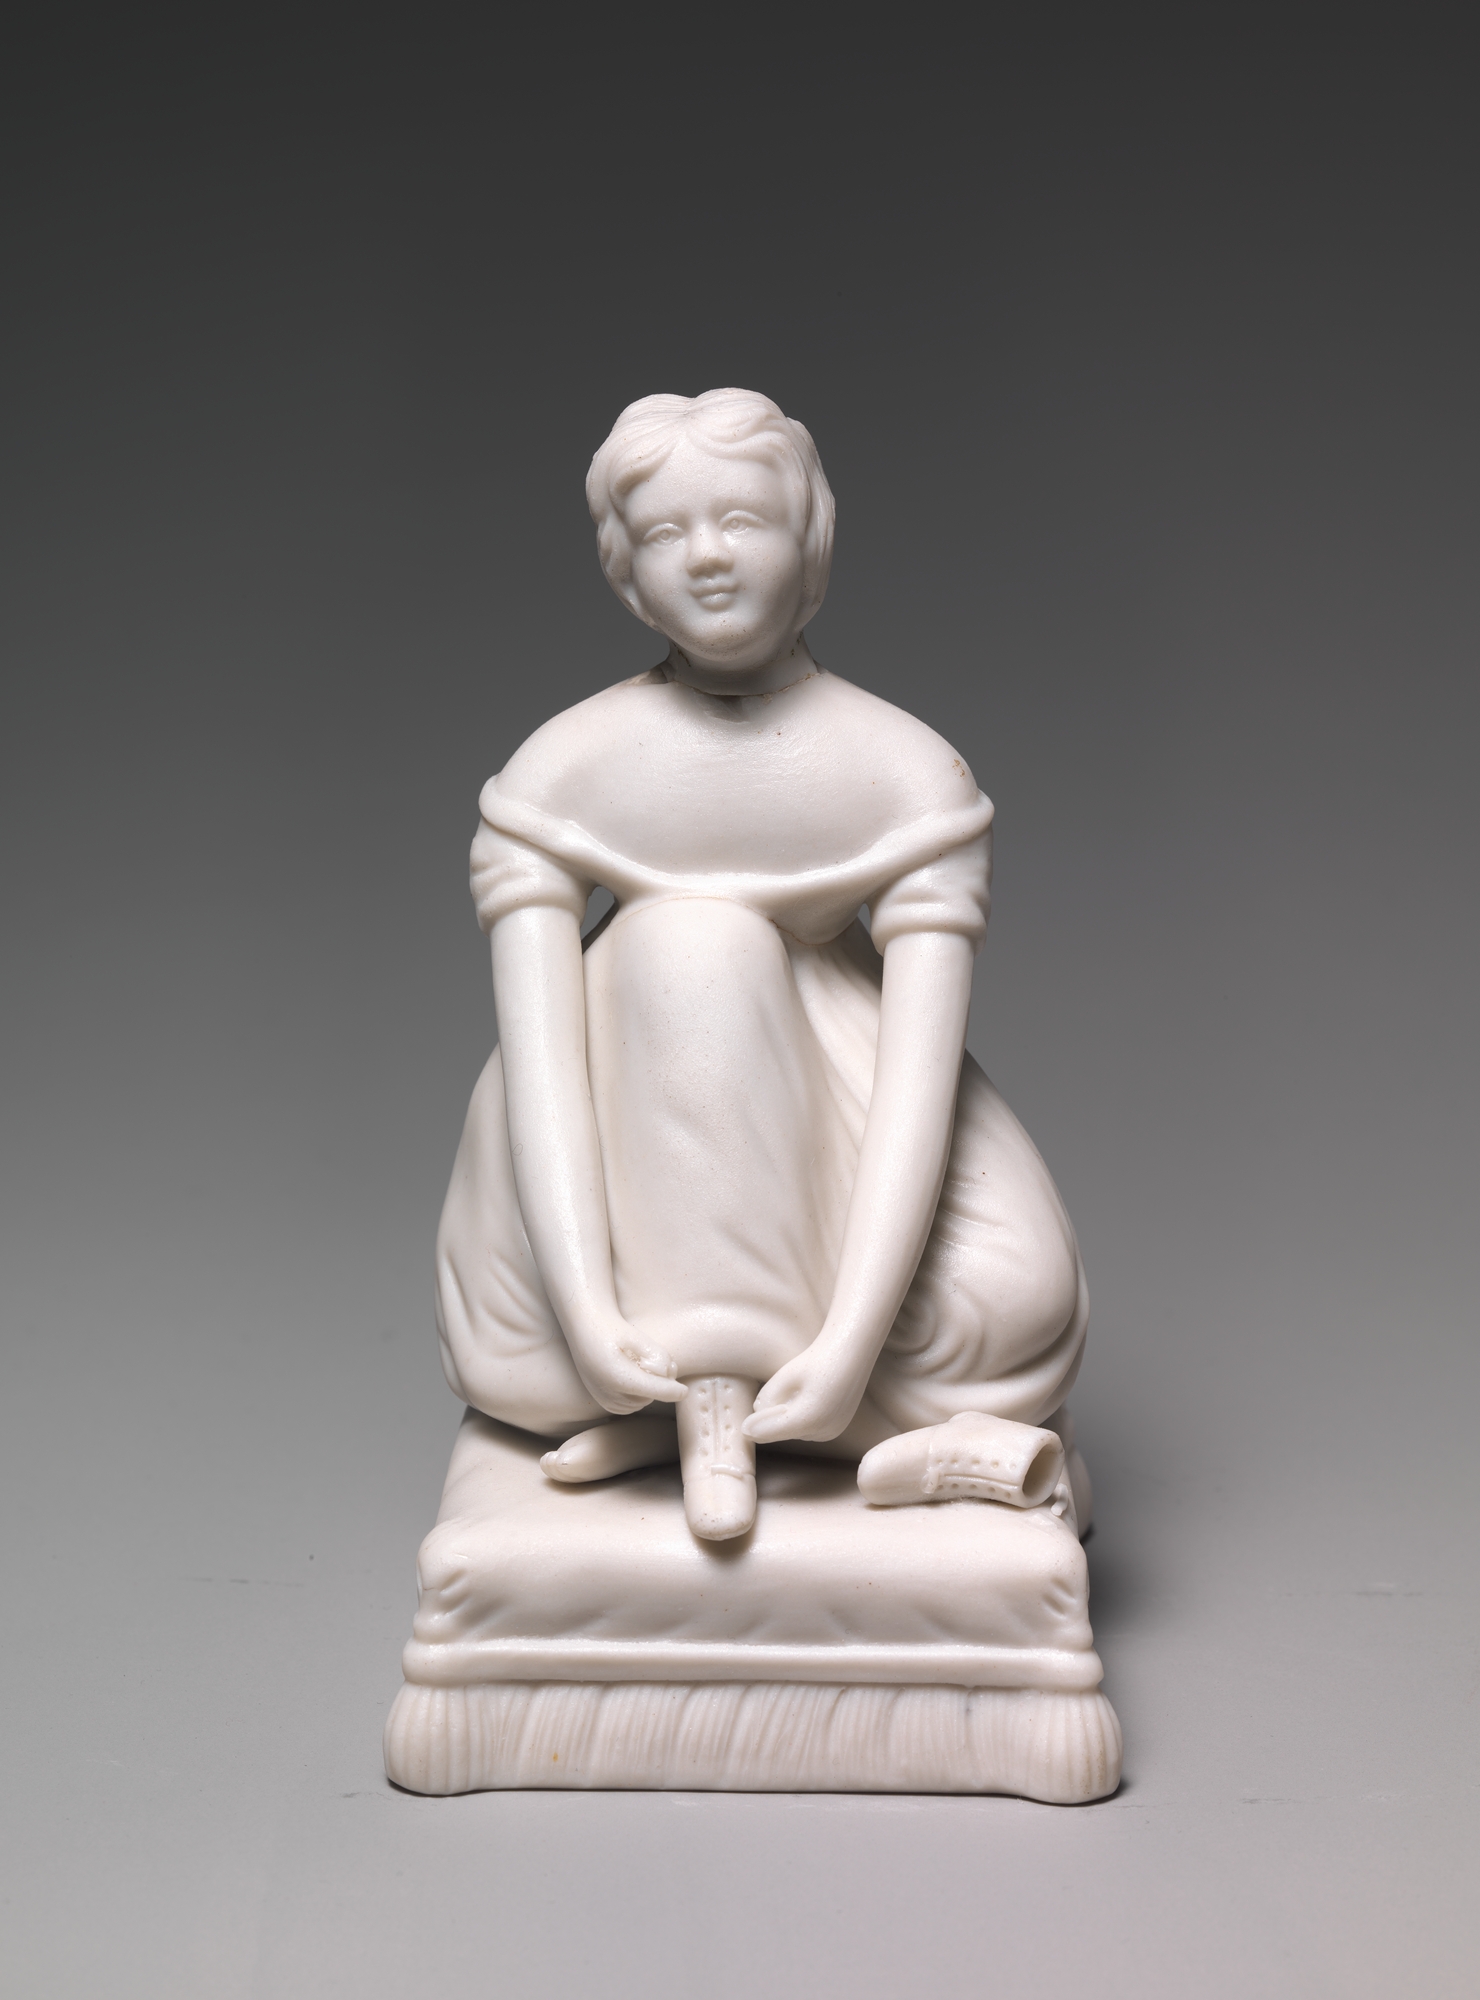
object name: figure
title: Female Figure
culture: american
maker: united states pottery company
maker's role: maker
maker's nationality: american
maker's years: 1852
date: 1853-1858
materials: porcelain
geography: united states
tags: women